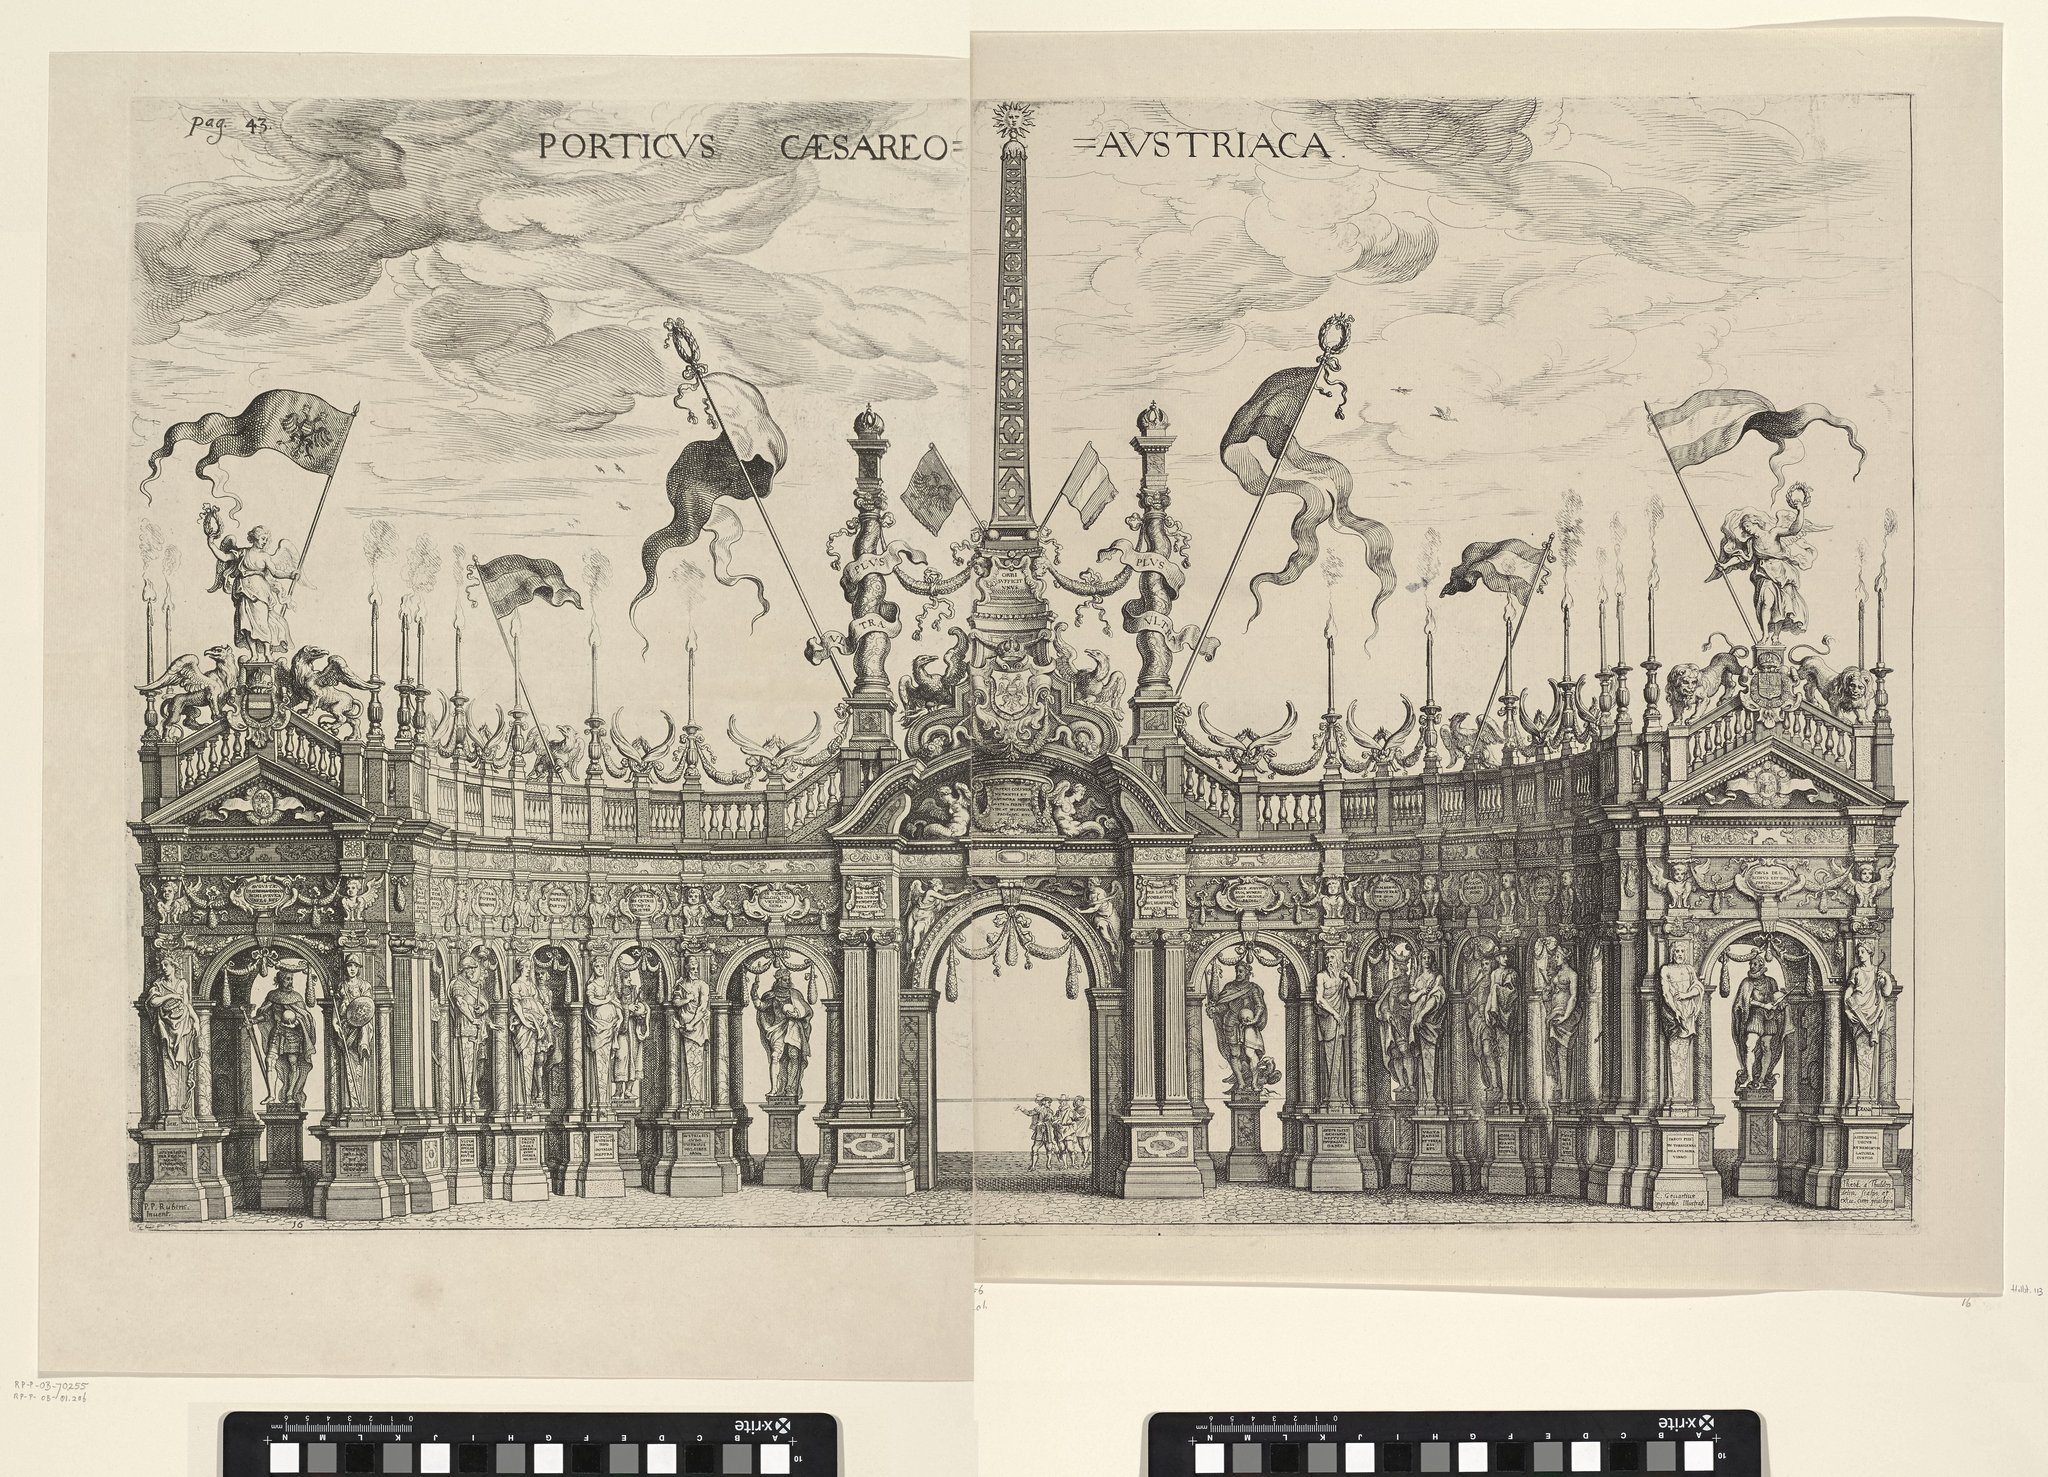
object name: print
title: Zuilengang van de keizers; intocht van Ferdinand te Antwerpen in 1635 (nr. 16)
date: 1639-1641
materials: paper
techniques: engraving, etching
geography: southern netherlands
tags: brussels, landvoogd der zuidelijke nederlanden ferdinand van oostenrijk, triumphal entry and public reception, pageant, 'entrée solennelle', 'joyeuse entrée', antwerp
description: Oorspronkelijk gebruikt als illustratie in: C. Gevartius, Pompa introitus ... Ferdinandi Austriaci Hispaniarum Infantis ... a S.P.Q. Antverp, decreta et adornata, cum ... ad Norlingam parta victoria Antverpiam ... adventu suo bearet ... 1635 : arcus, pegmata iconesque a Pet. Paulo Rubenio ... inventas & delineatas inscriptionibus & elogiis ornabat, libroque commentario illustrabat, Theodoor van Thulden en Joannes Meursius, Antwerpen 1641, pl. 16. Dit object is omwille van een betere presentatie virtueel samengevoegd, maar bestaat fysiek uit losse onderdelen.